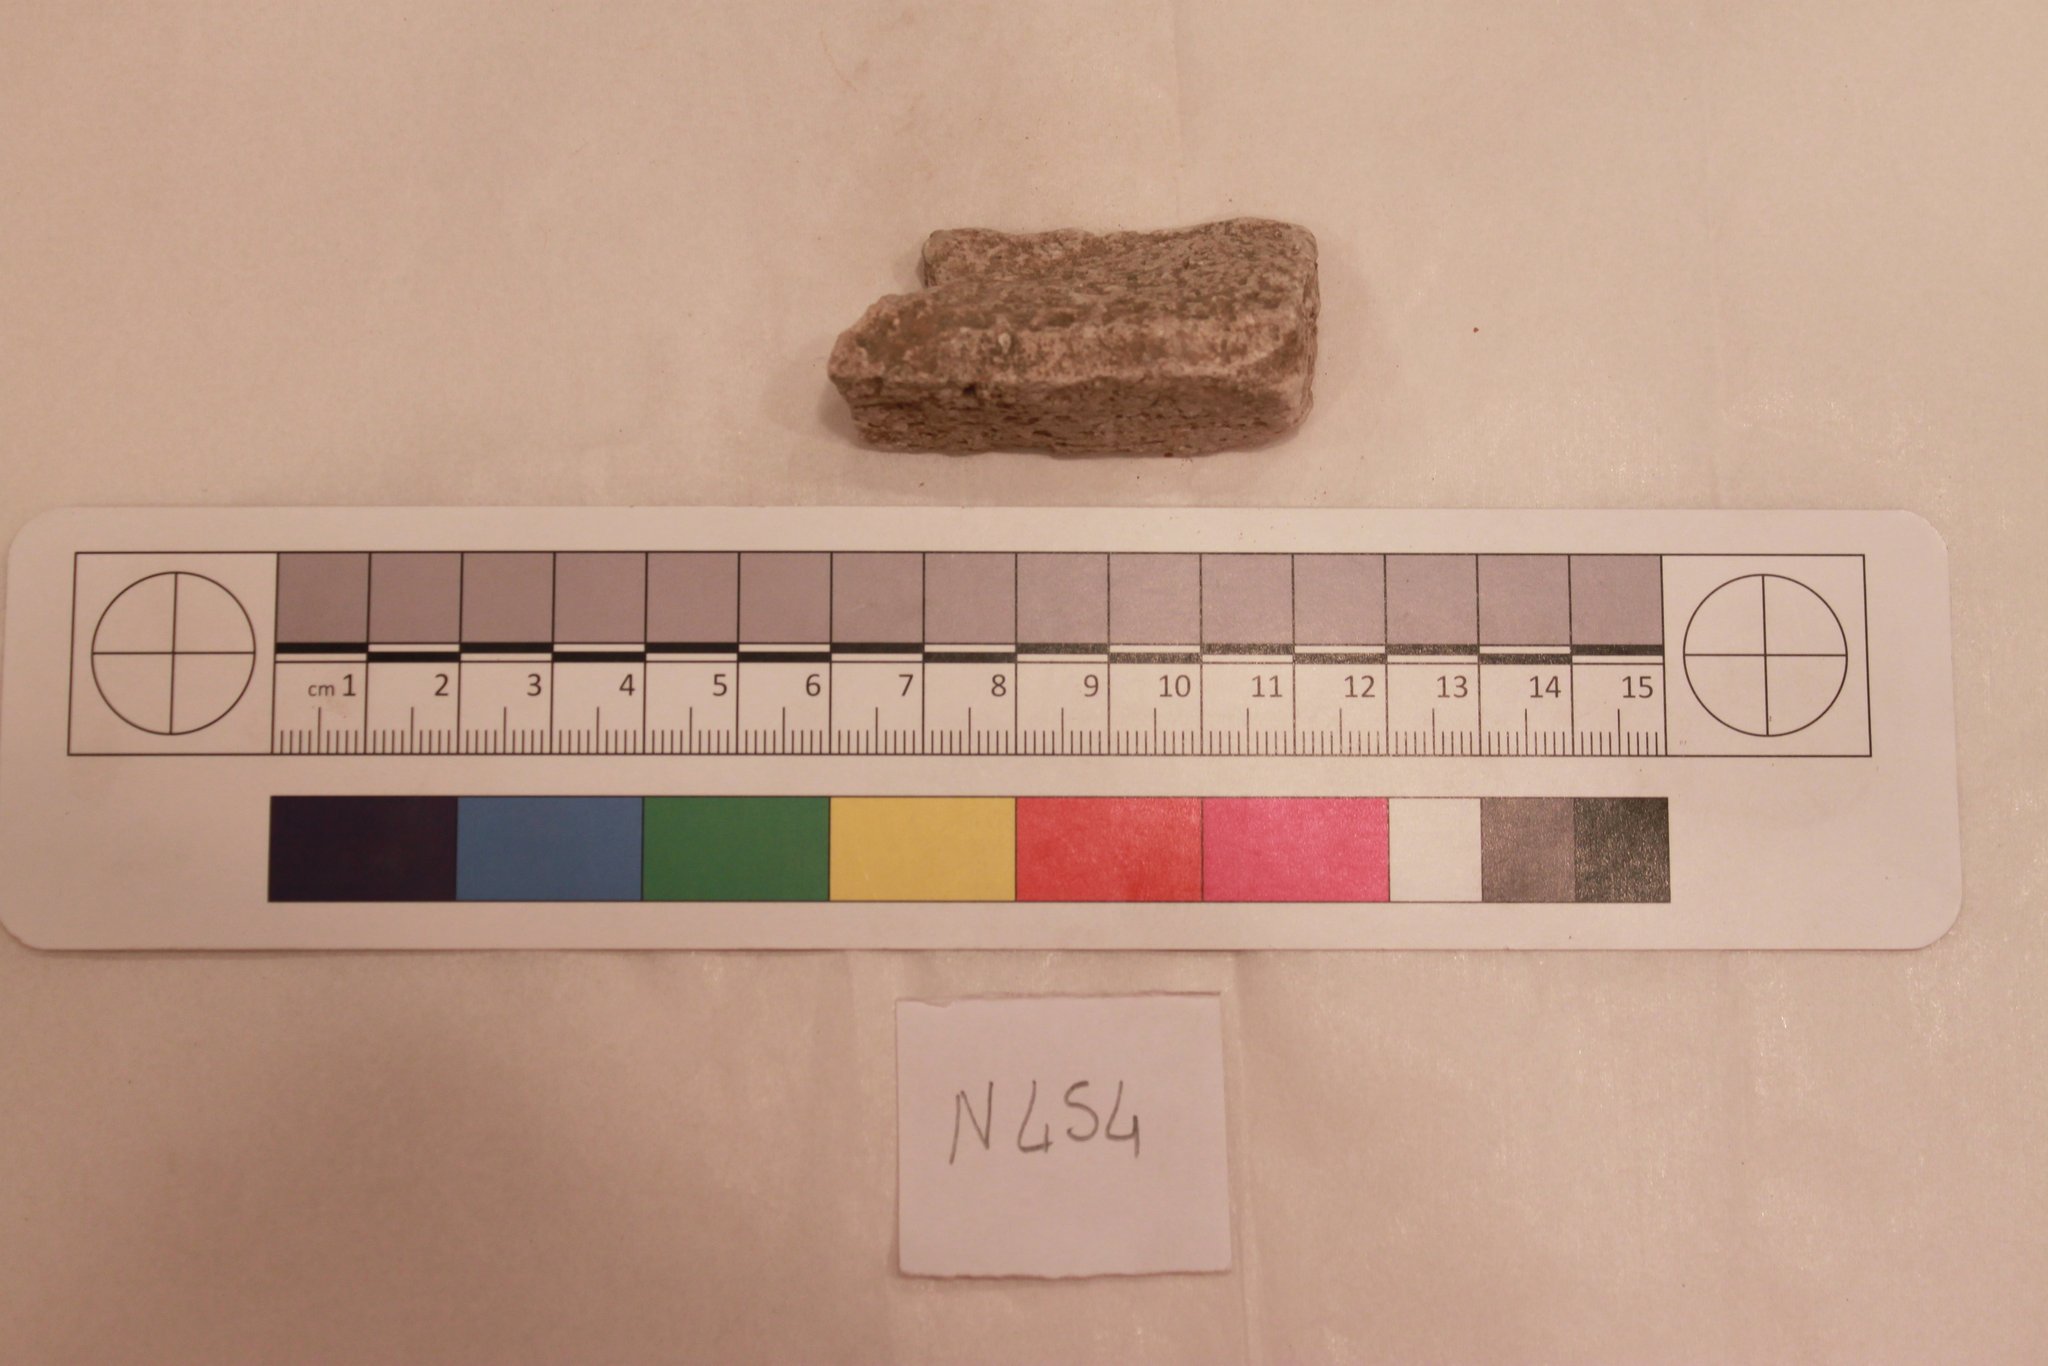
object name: fragment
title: Stucco Fragment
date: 701-1200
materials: plaster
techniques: carving, painting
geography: iran